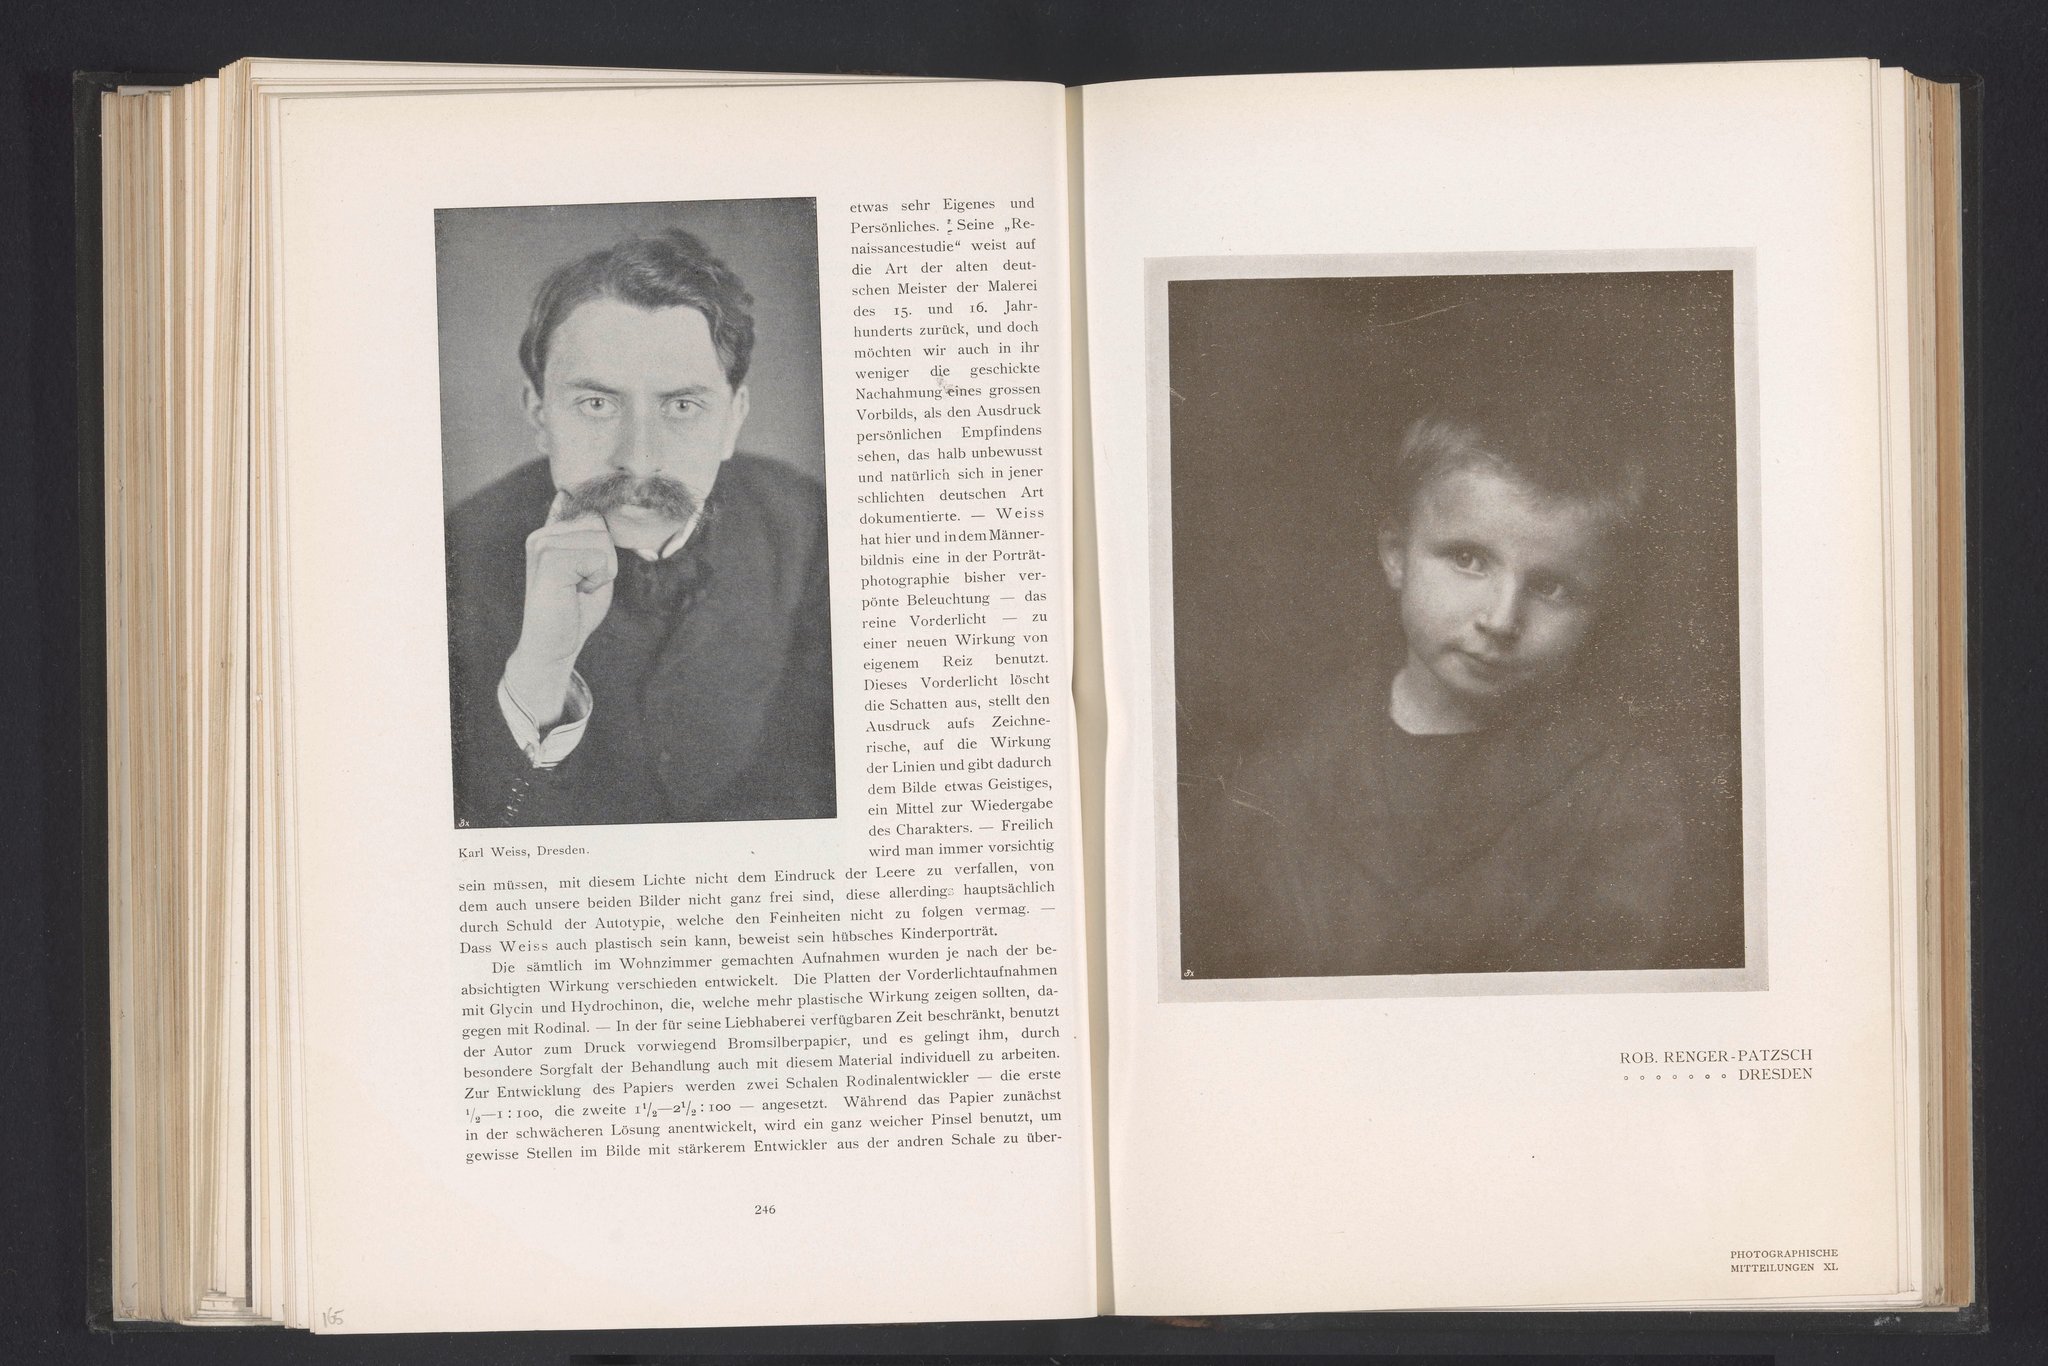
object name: page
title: Portret van een onbekende jongen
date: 1898-1903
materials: paper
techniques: autotype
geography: dresden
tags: historical persons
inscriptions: monogram: ‘BX’, inscription: ‘Photographische Mitteilungen XL’